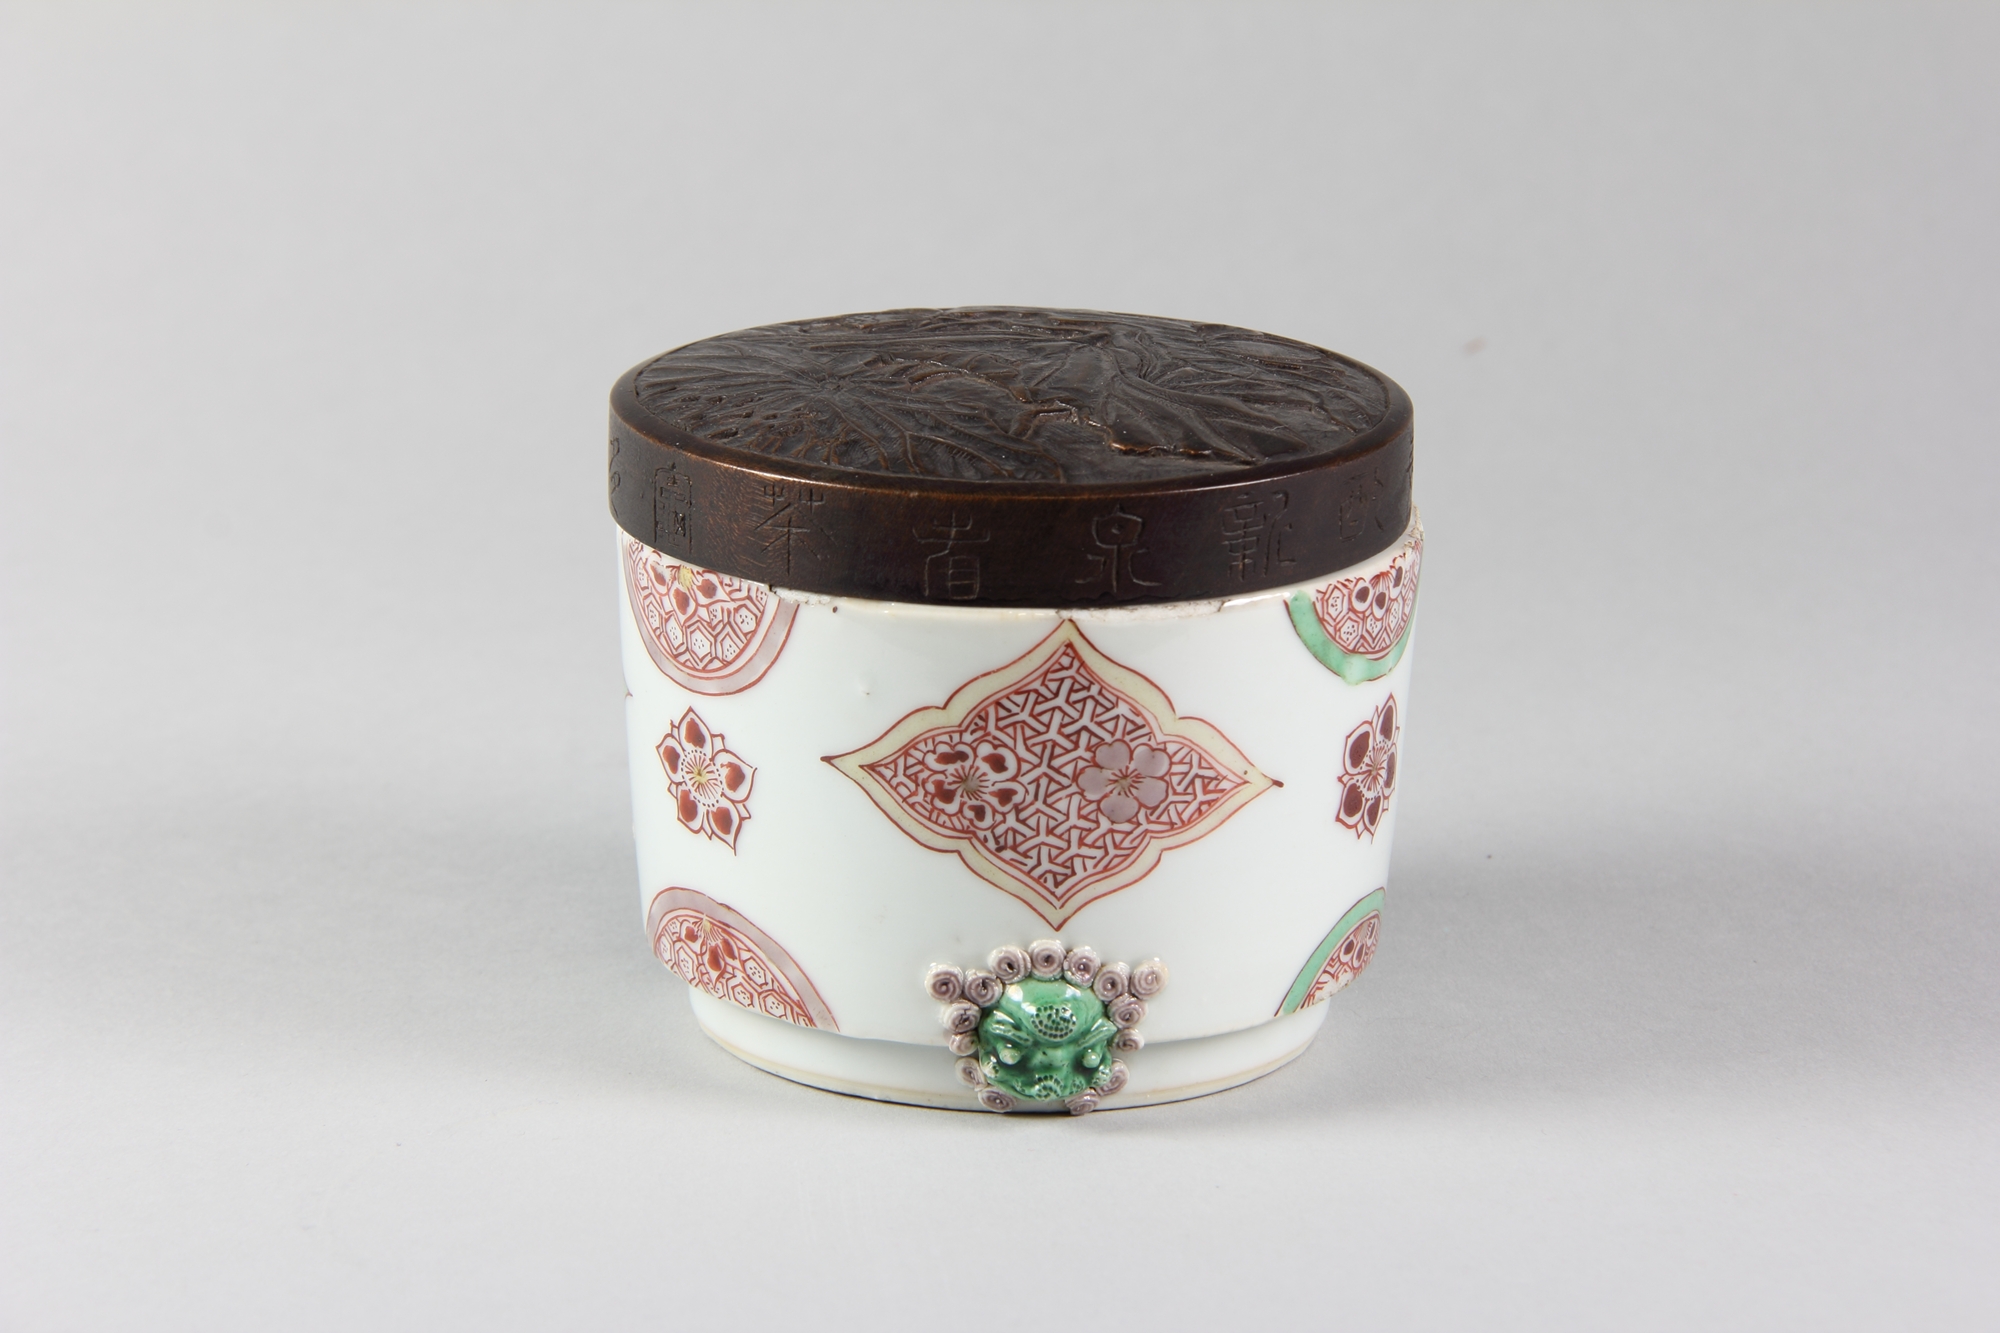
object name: incense burner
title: Incense burner with lion-head décor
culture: chinese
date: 1701-1800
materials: enamel, porcelain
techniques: overglaze, painting, polychrome